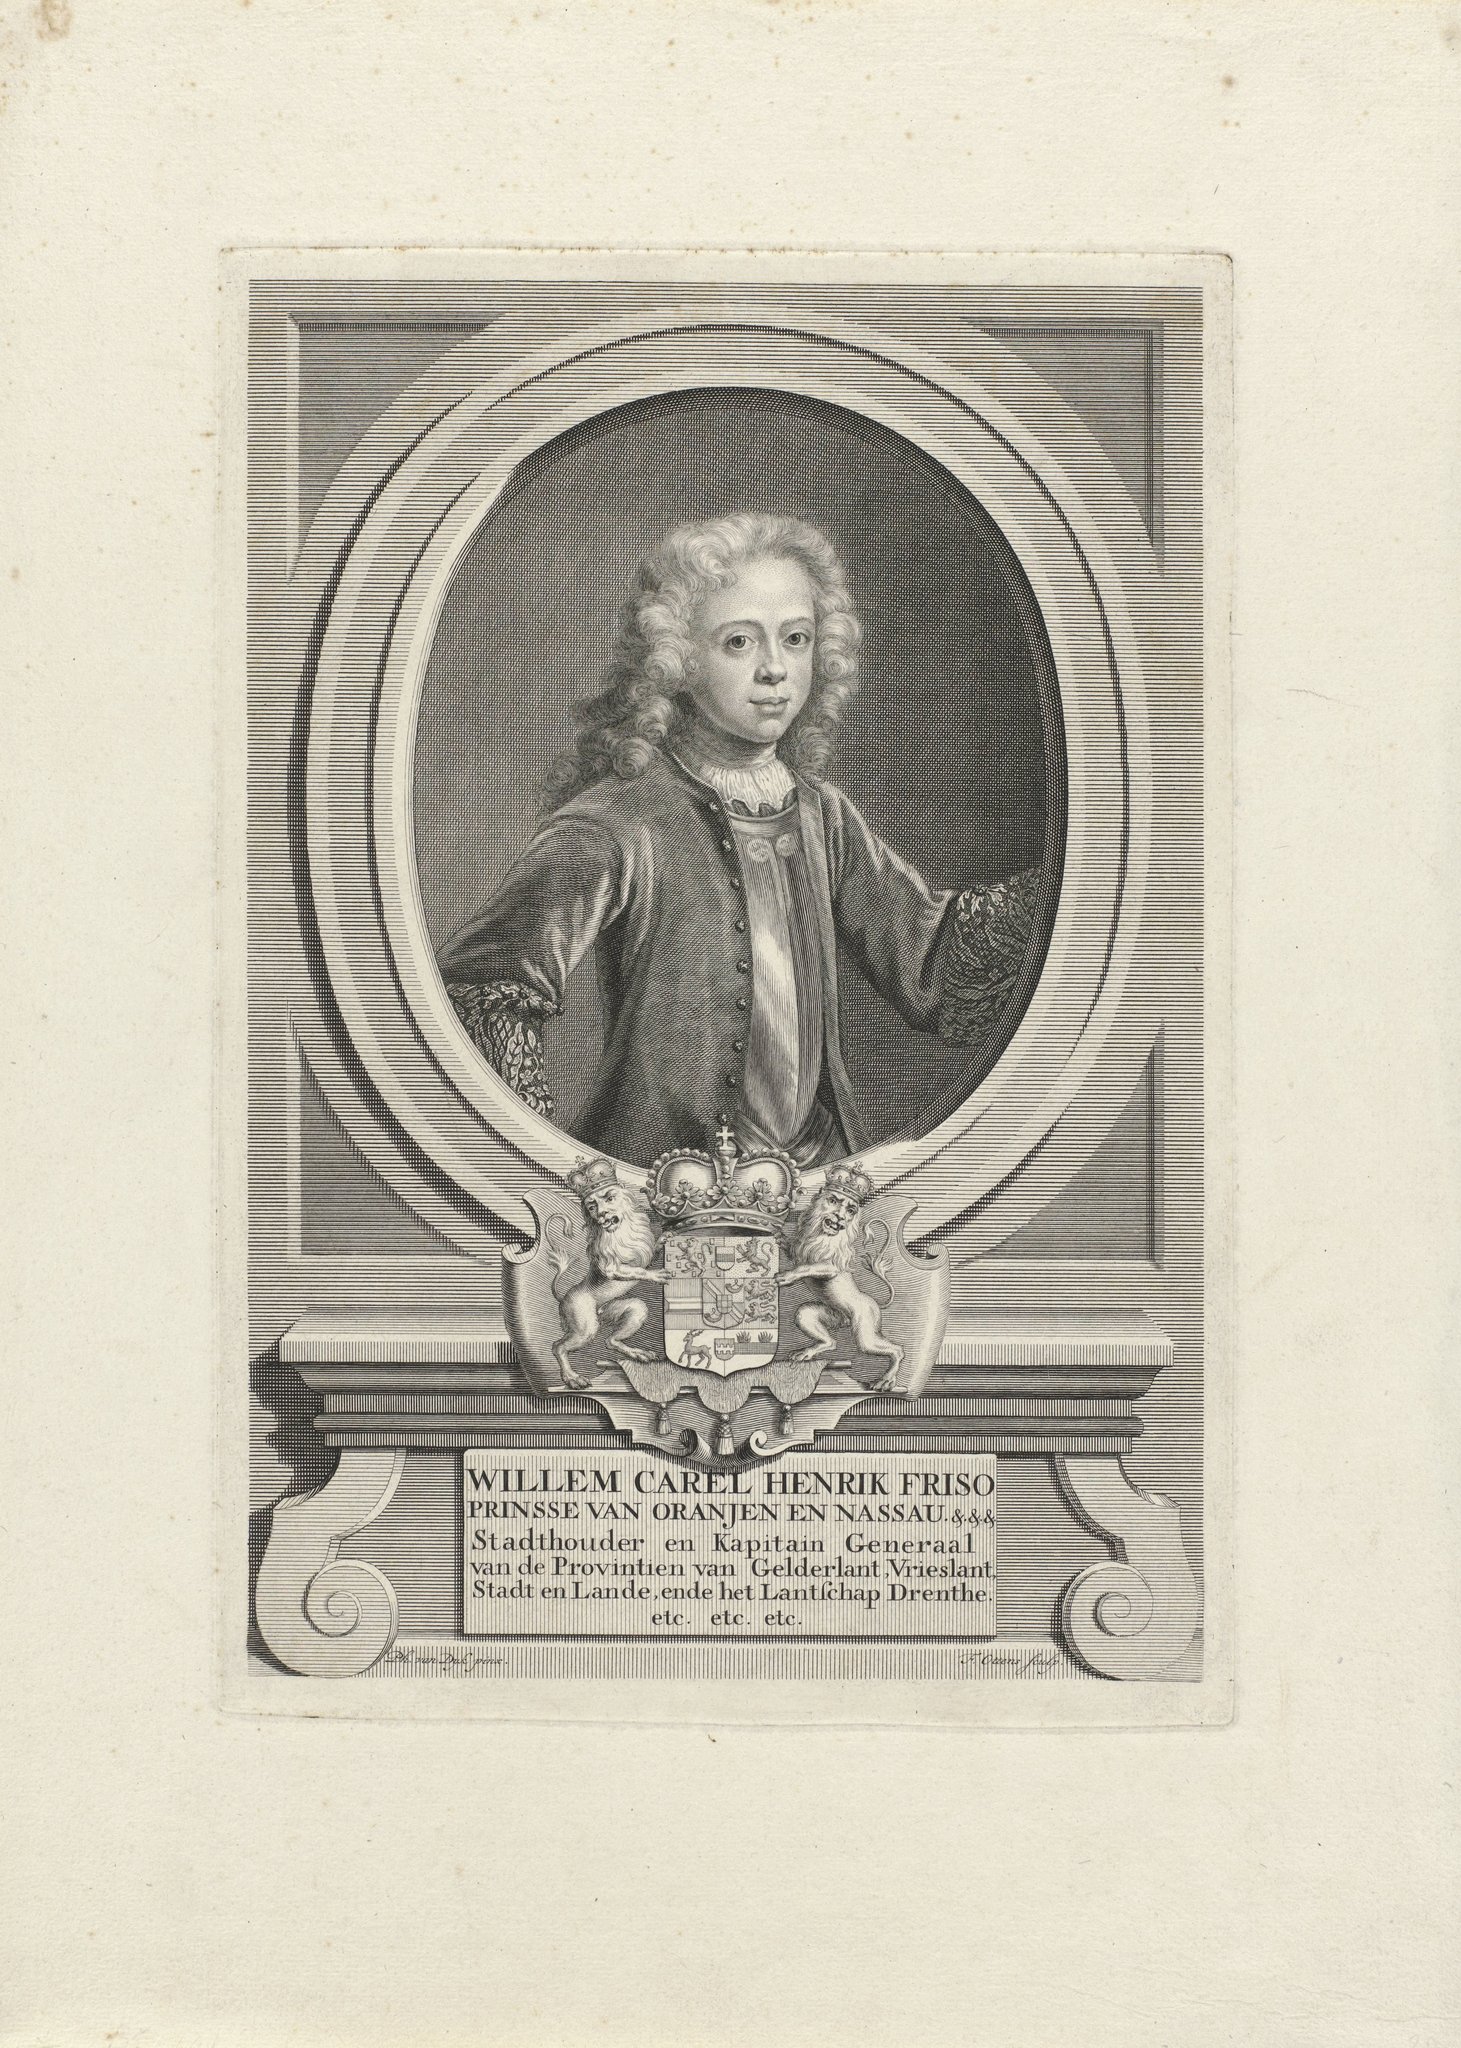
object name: print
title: Portret van Willem IV, prins van Oranje-Nassau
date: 1725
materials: paper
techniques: engraving, etching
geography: northern netherlands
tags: willem iv (prins van oranje-nassau)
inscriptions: collector's mark: Lugt 240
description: De hier vermelde titel verwijst naar de hoogst verkregen titel van de geportretteerde, niet per se naar de titel die de geportretteerde op deze voorstelling draagt.